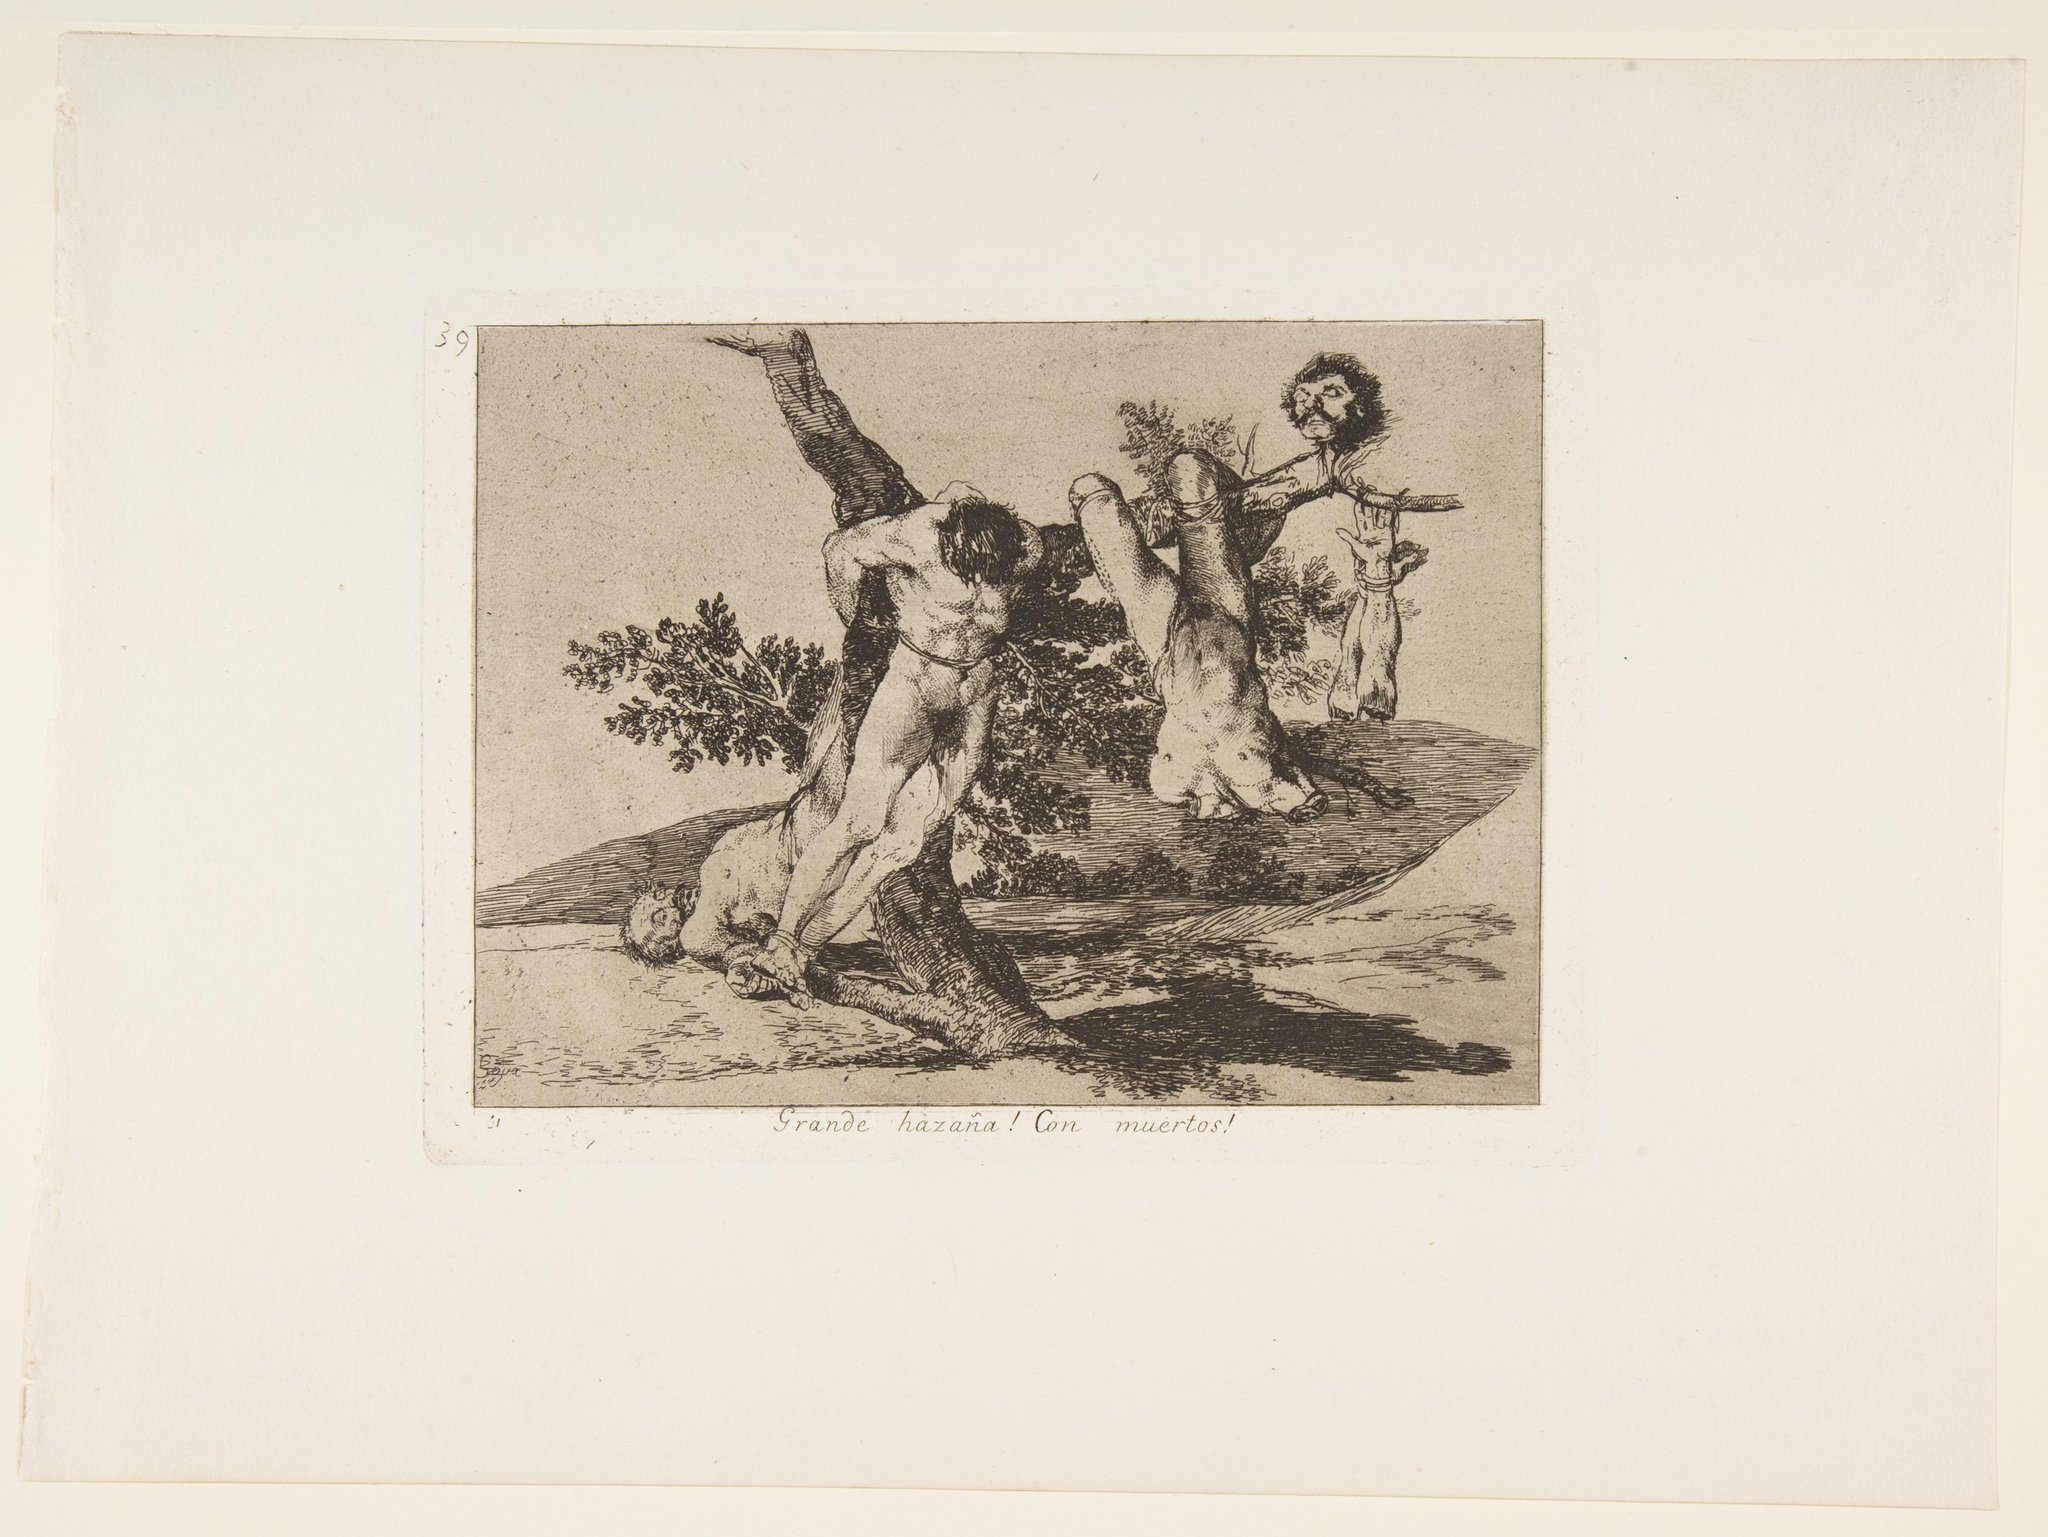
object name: print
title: Plate 39 from "The Disasters of War" (Los Desastres de La Guerra): 'An heroic feat! With dead men!' (Grande hazaña! Con muertos!)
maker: goya (francisco de goya y lucientes)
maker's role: artist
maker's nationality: spanish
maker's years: 1746-1828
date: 1810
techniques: drypoint, etching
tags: heads,male nudes,trees,death